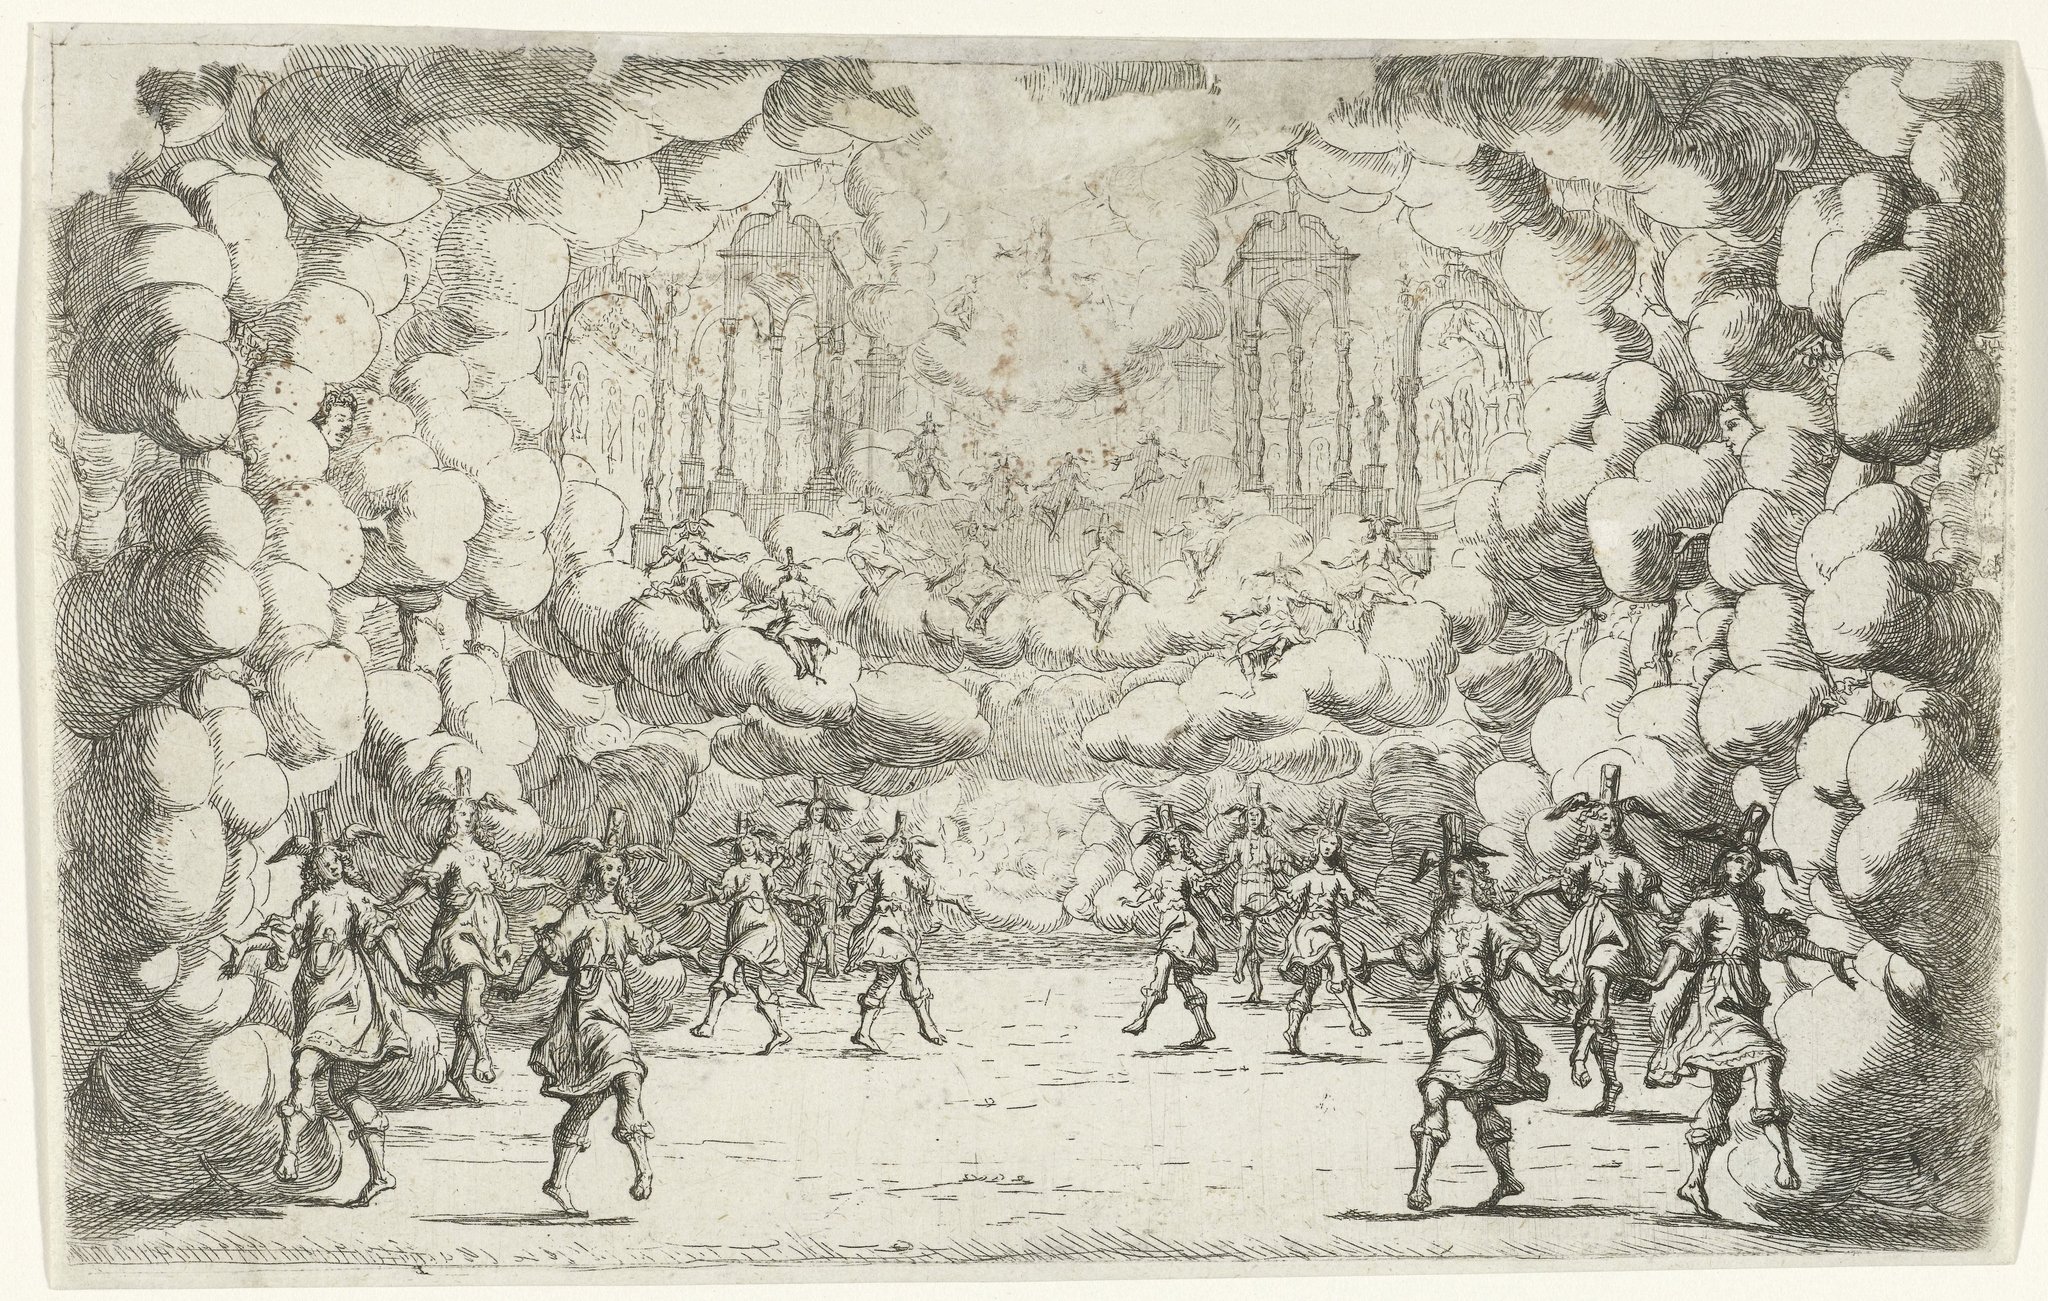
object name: print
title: Het wolkenpaleis van den Tijd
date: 1663-1674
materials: paper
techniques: etching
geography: vienna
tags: set, scenery ~ stage, theatre, theatrical performance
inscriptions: collector's mark: Lugt 2228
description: Gezicht op een paleis tussen de wolken. Op de vloer dansende vrouwen met gevleugelde zandlopers op hun hoofd. In de wolken zitten eveneens vrouwen met gevleugelde zandlopers.